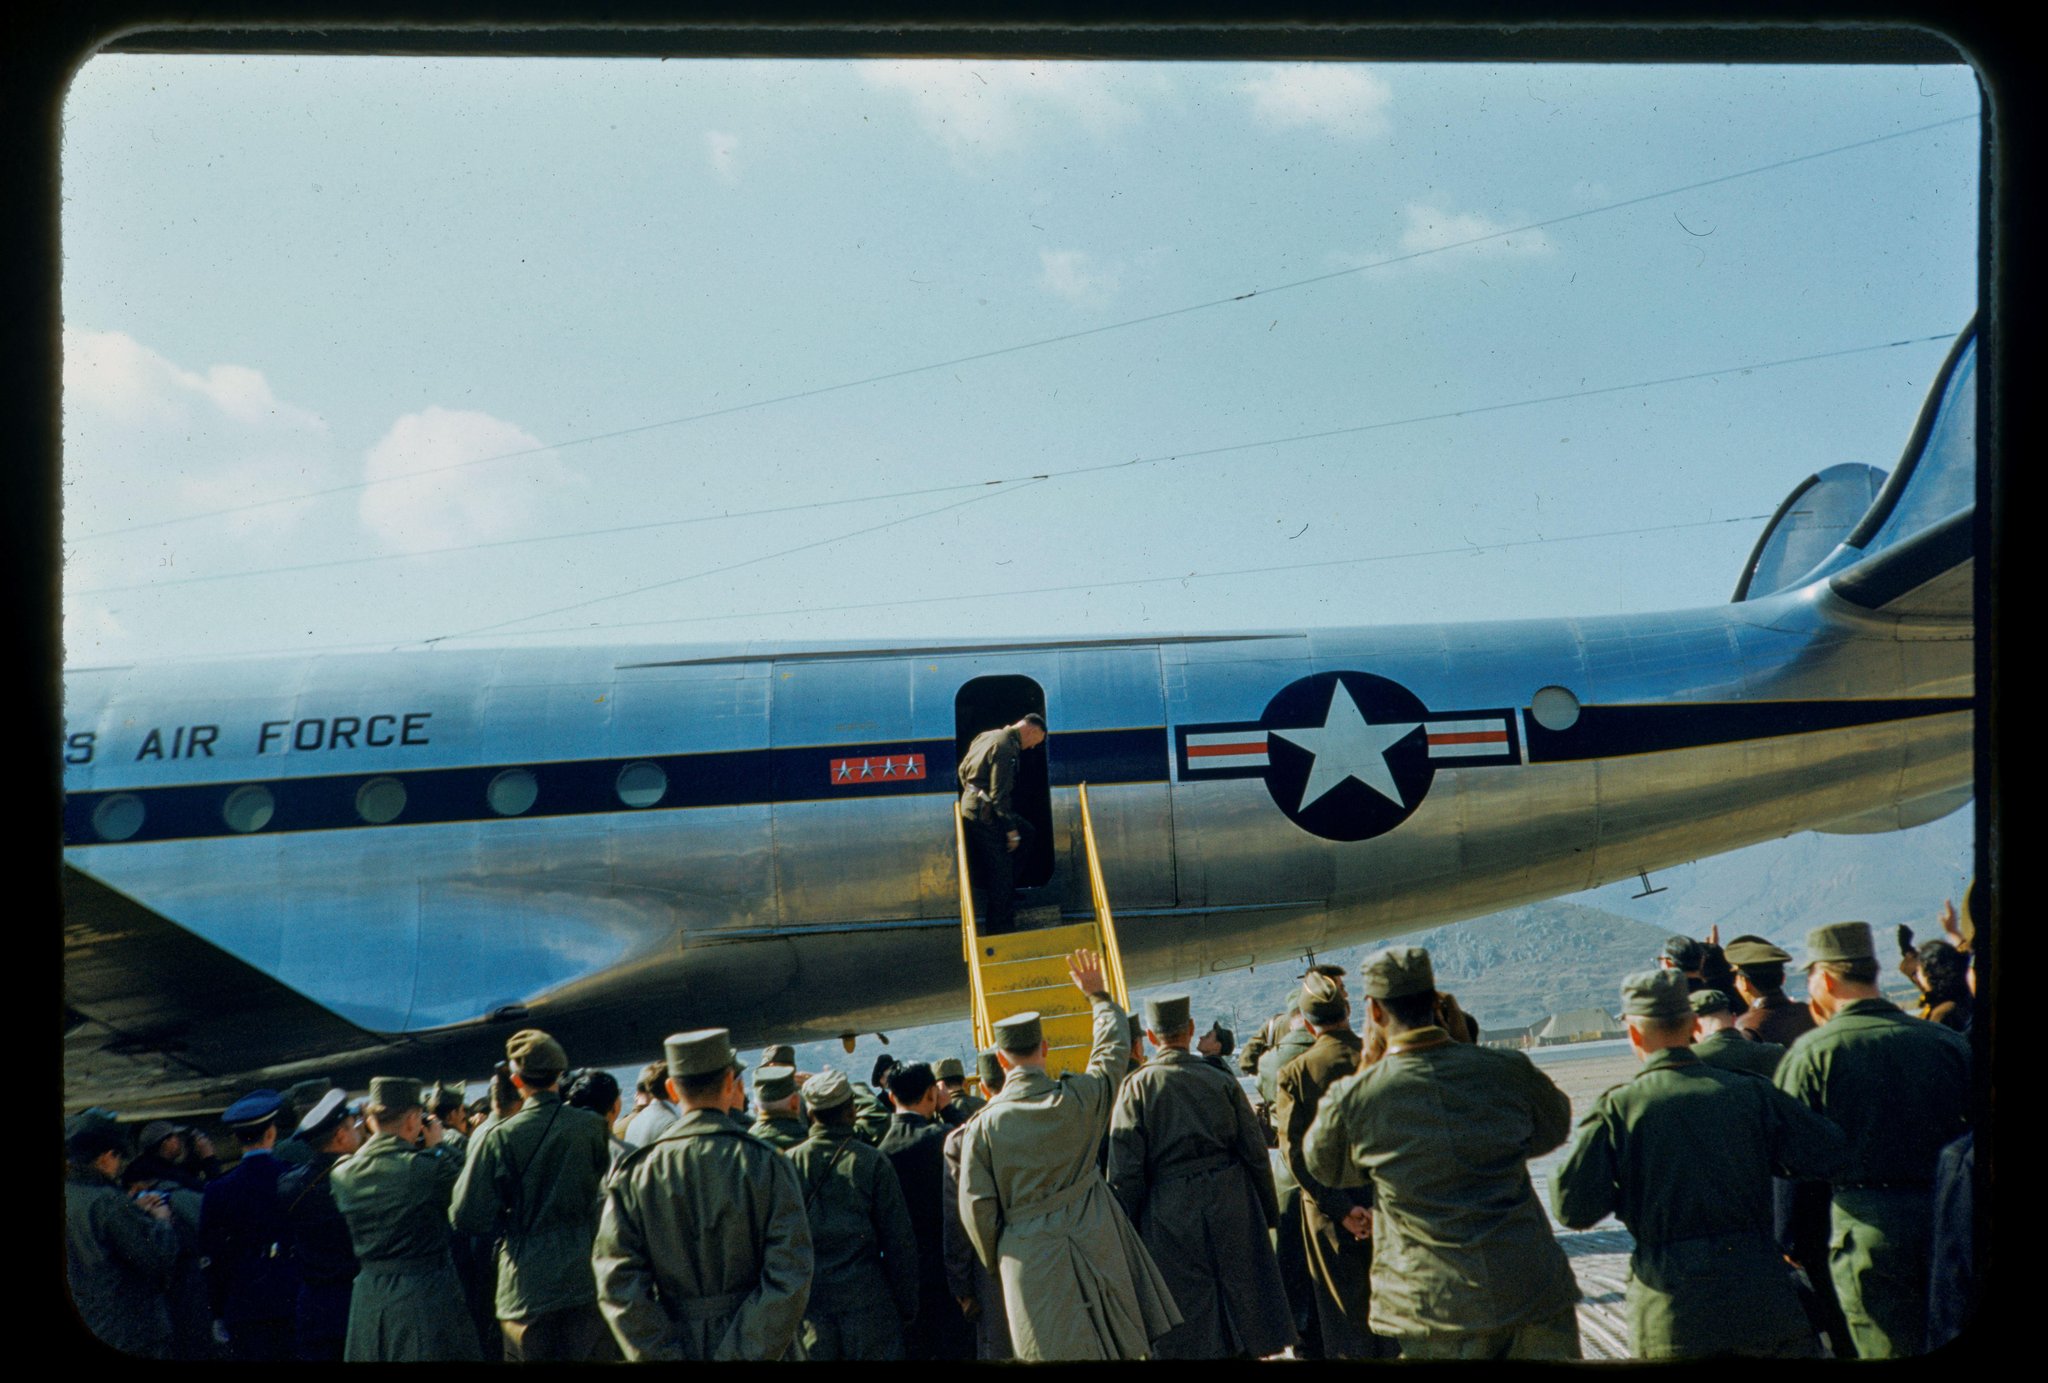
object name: color slide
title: De Dag van de Vloot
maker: david ketel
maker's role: diplomaat, sinoloog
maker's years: 1913-2008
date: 1951-1953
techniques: slide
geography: korea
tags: united nations